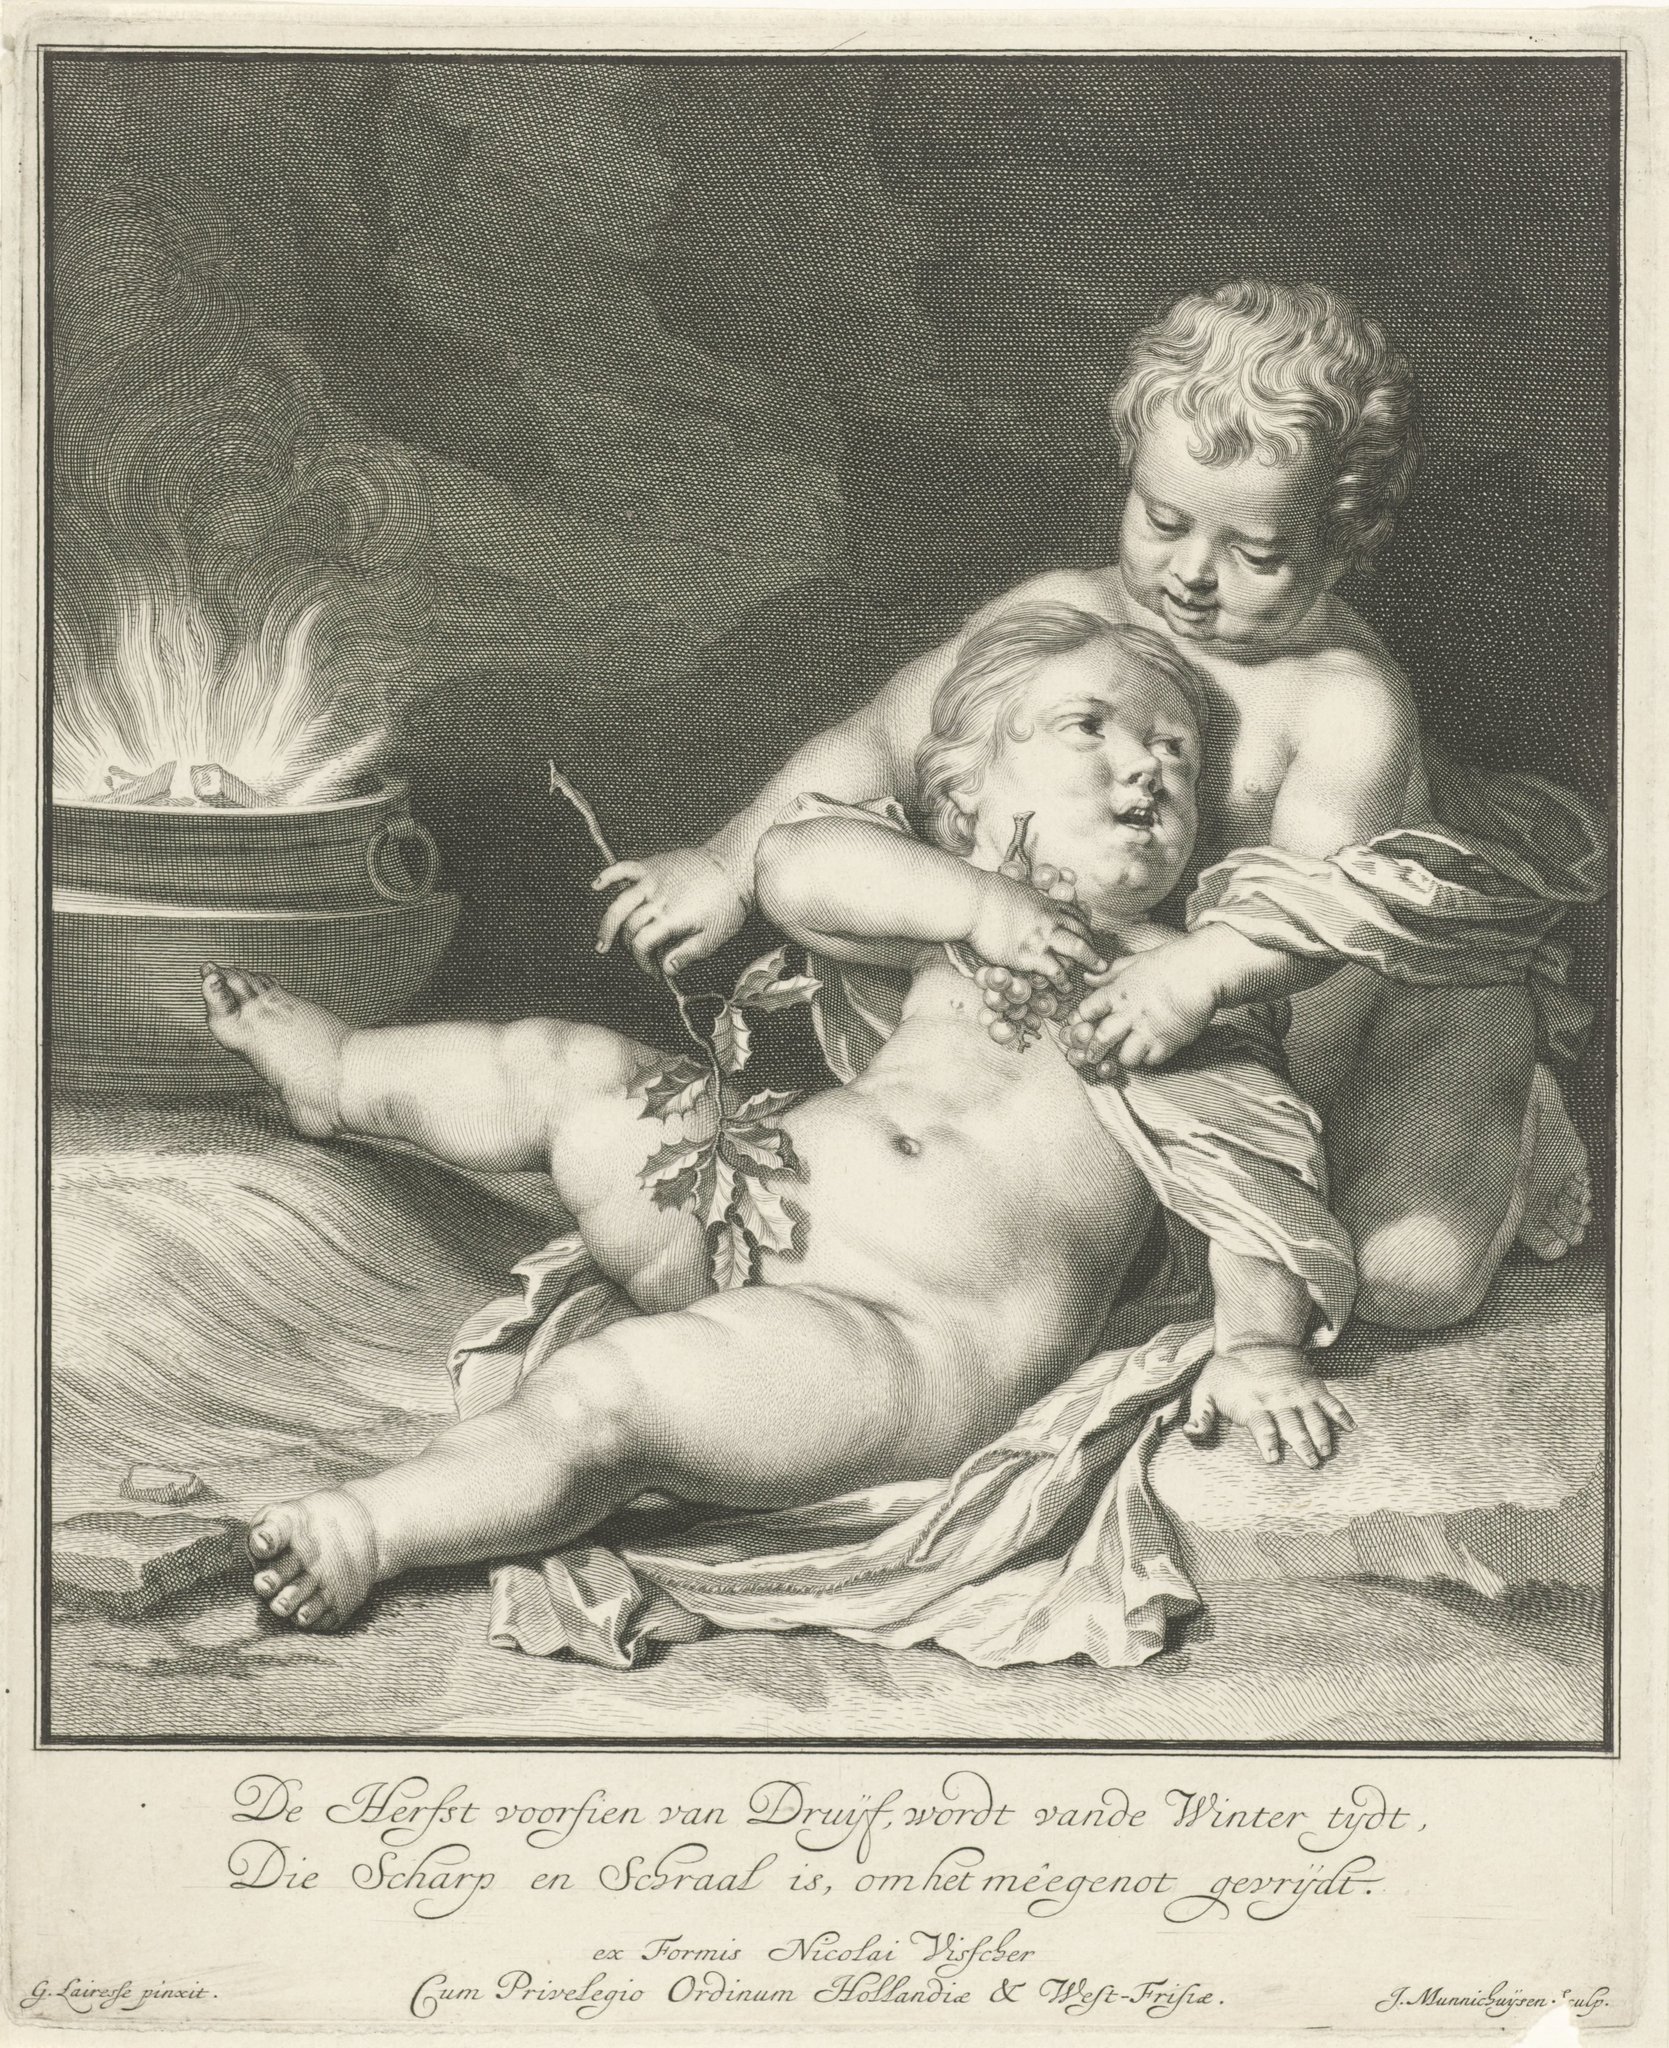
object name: print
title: Twee kinderen met druiventros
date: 1664-1721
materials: paper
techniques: engraving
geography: amsterdam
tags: children's bacchanal, warming oneself at a fire (or hearth, stove, fire-pan, brazier), cupids: 'amores', 'amoretti', 'putti', bunch of grapes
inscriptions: collector's mark: Lugt 2228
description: Twee naakte kinderen bij een vuurpot. Het ene kind probeert druiven van de druiventros van de ander te ontfutselen. Onder de voorstelling een tweeregelig vers in het Nederlands, waarin wordt aangegeven dat druiven in de wintertijd fel begeerd worden.